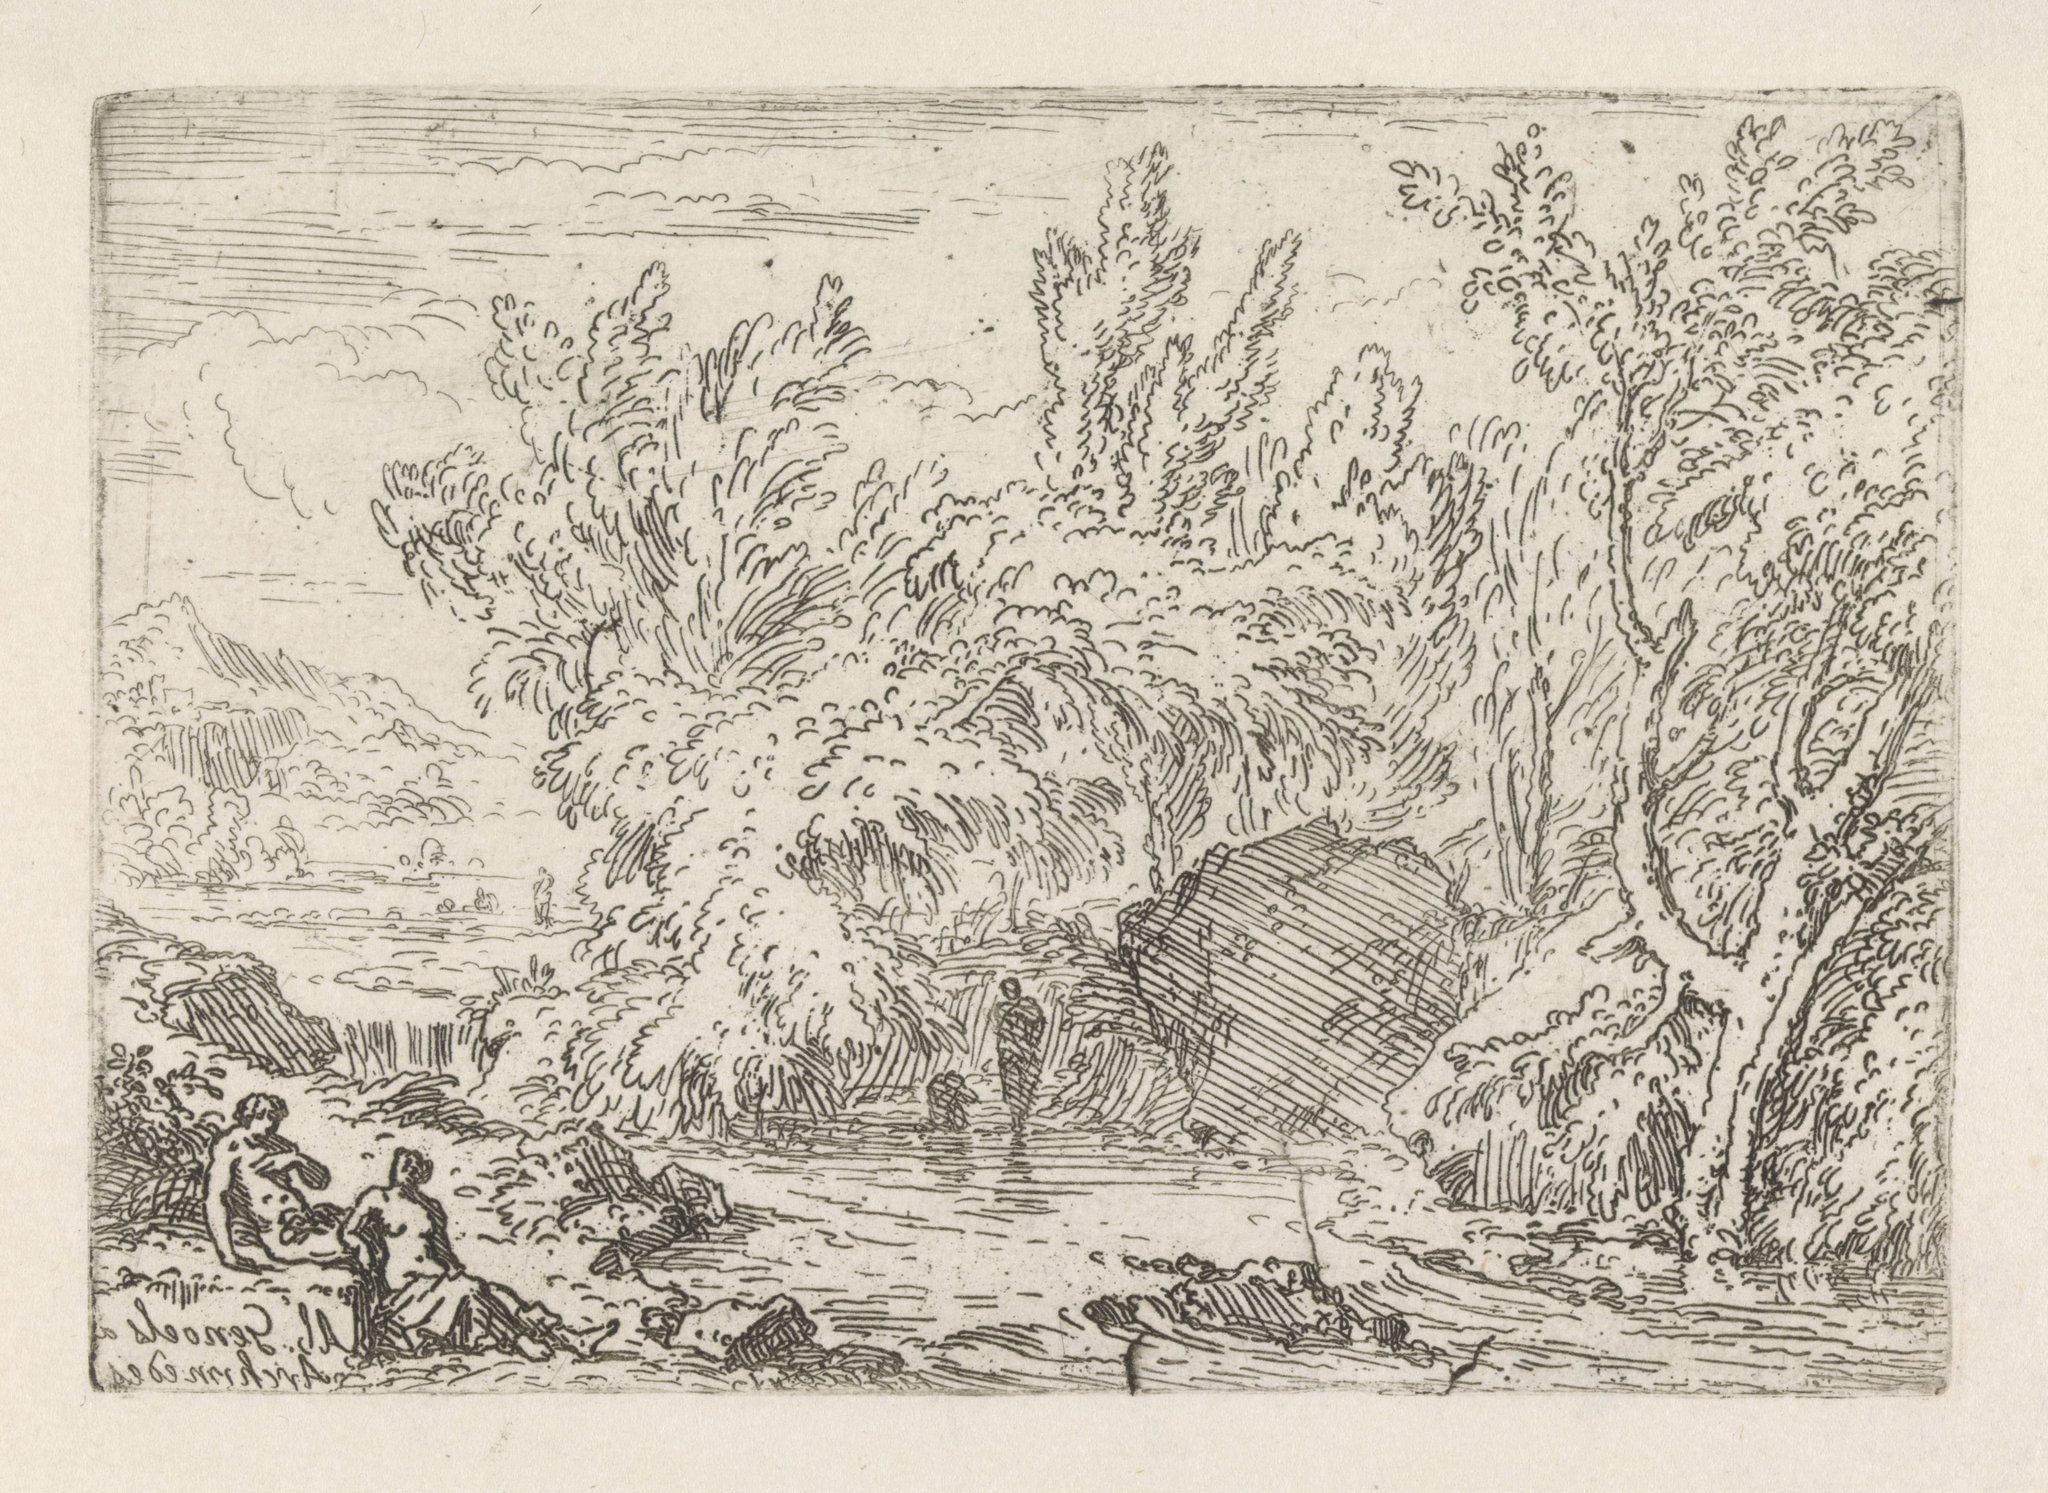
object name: print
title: Arcadisch landschap met een rivier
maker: abraham genoels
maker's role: draughtsman, print maker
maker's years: 1640-1723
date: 1650-1723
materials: paper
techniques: etching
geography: paris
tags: waterfall, river (+ landscape with figures, staffage), pastorals, arcadian scenes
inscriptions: collector's mark: Lugt 240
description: Een Arcadisch landschap met een rivier en een waterval. Aan de oever enkele baders.